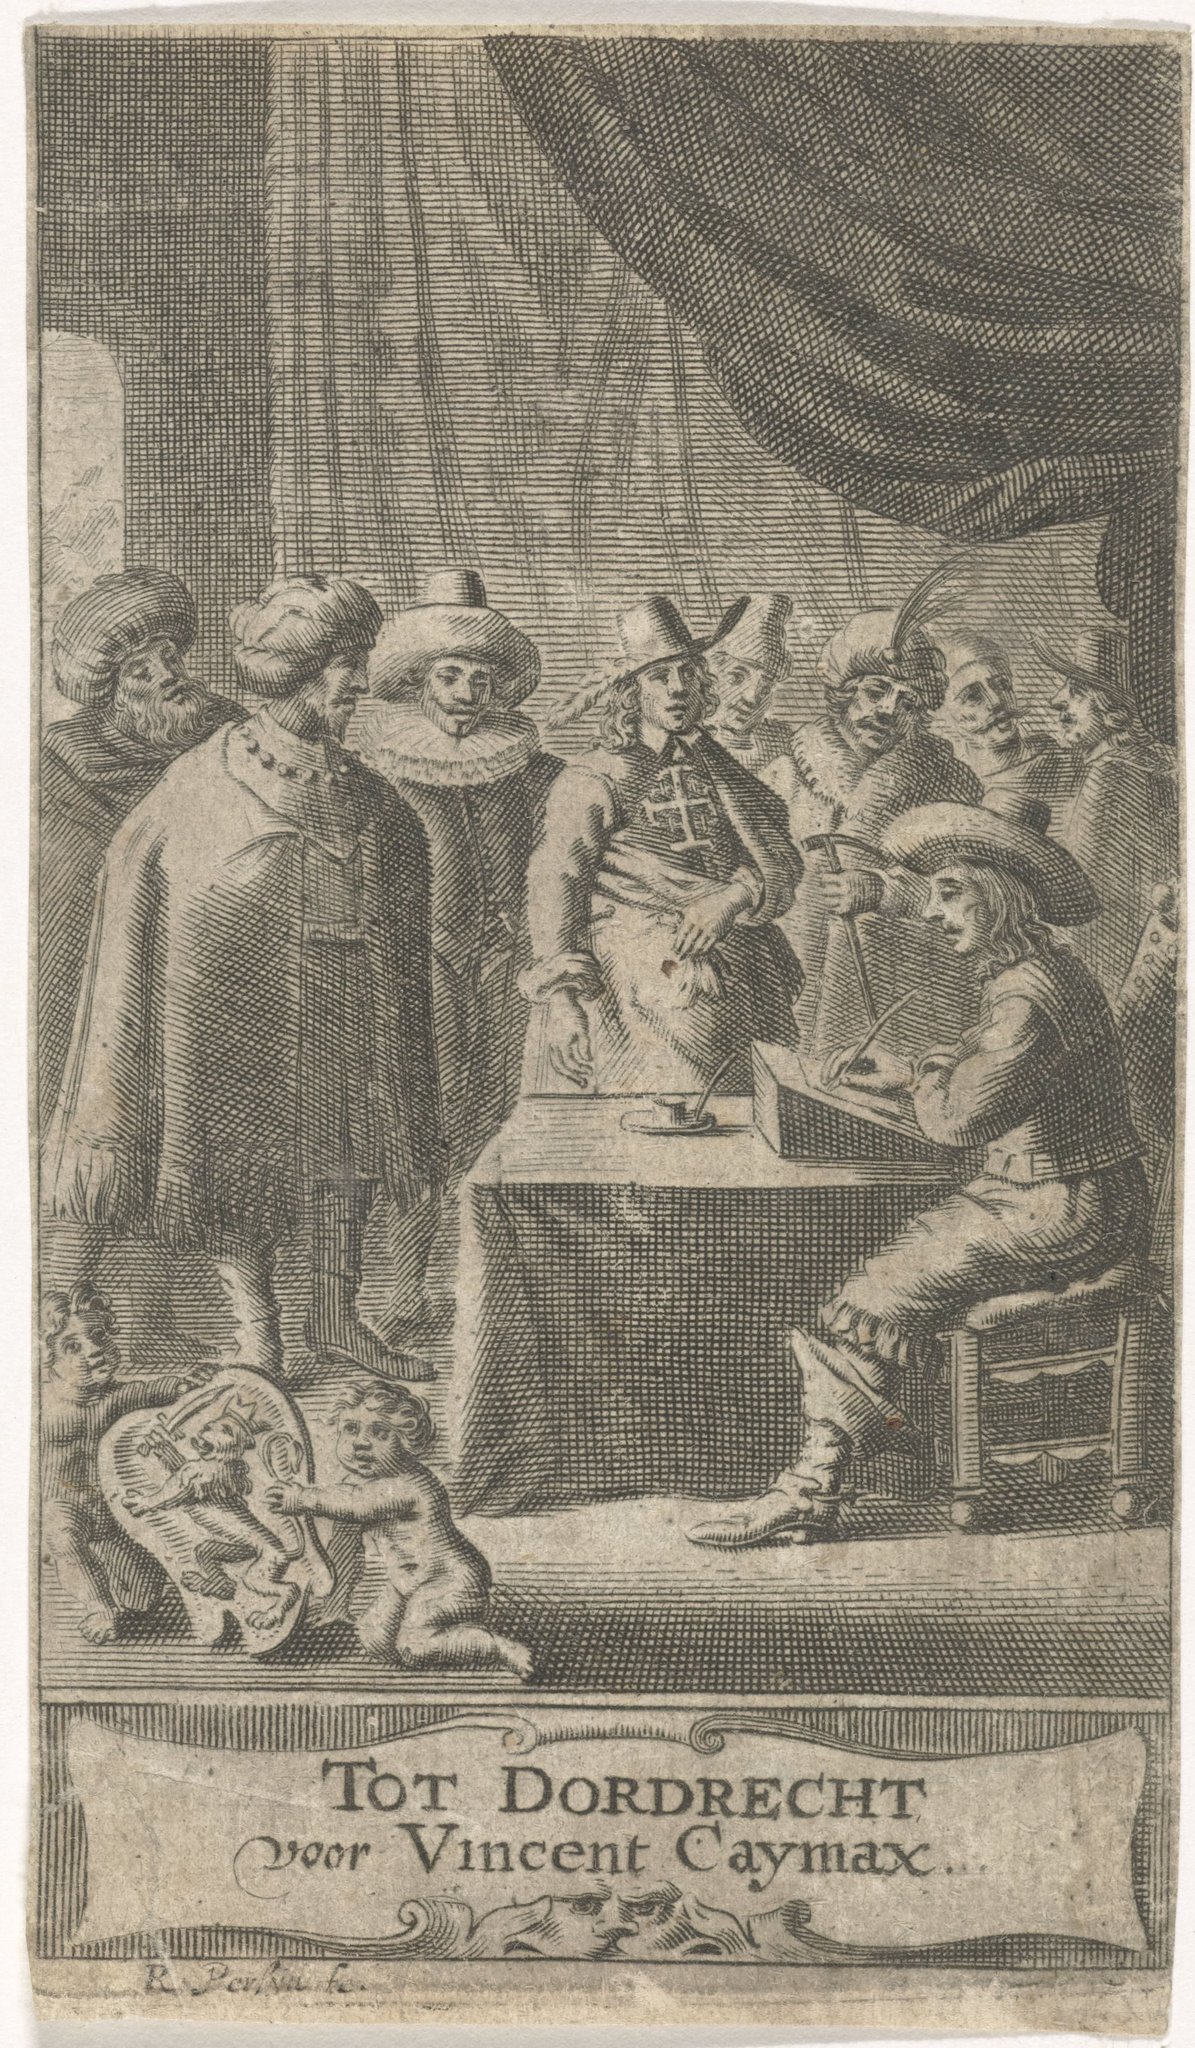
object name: print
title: Koopman aan schrijftafel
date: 1652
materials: paper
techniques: engraving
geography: dordrecht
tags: commercial traveller, symbols of particular nations, states, districts, etc., merchant, salesman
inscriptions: collector's mark: Lugt 2228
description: Vertrek met een koopman, zittend achter een schrijftafel. Hij wordt omringd door kooplieden uit allerlei landen. Linksonder twee putti die het wapenschild van de Republiek der Zeven Verenigde Nederlanden vasthouden.